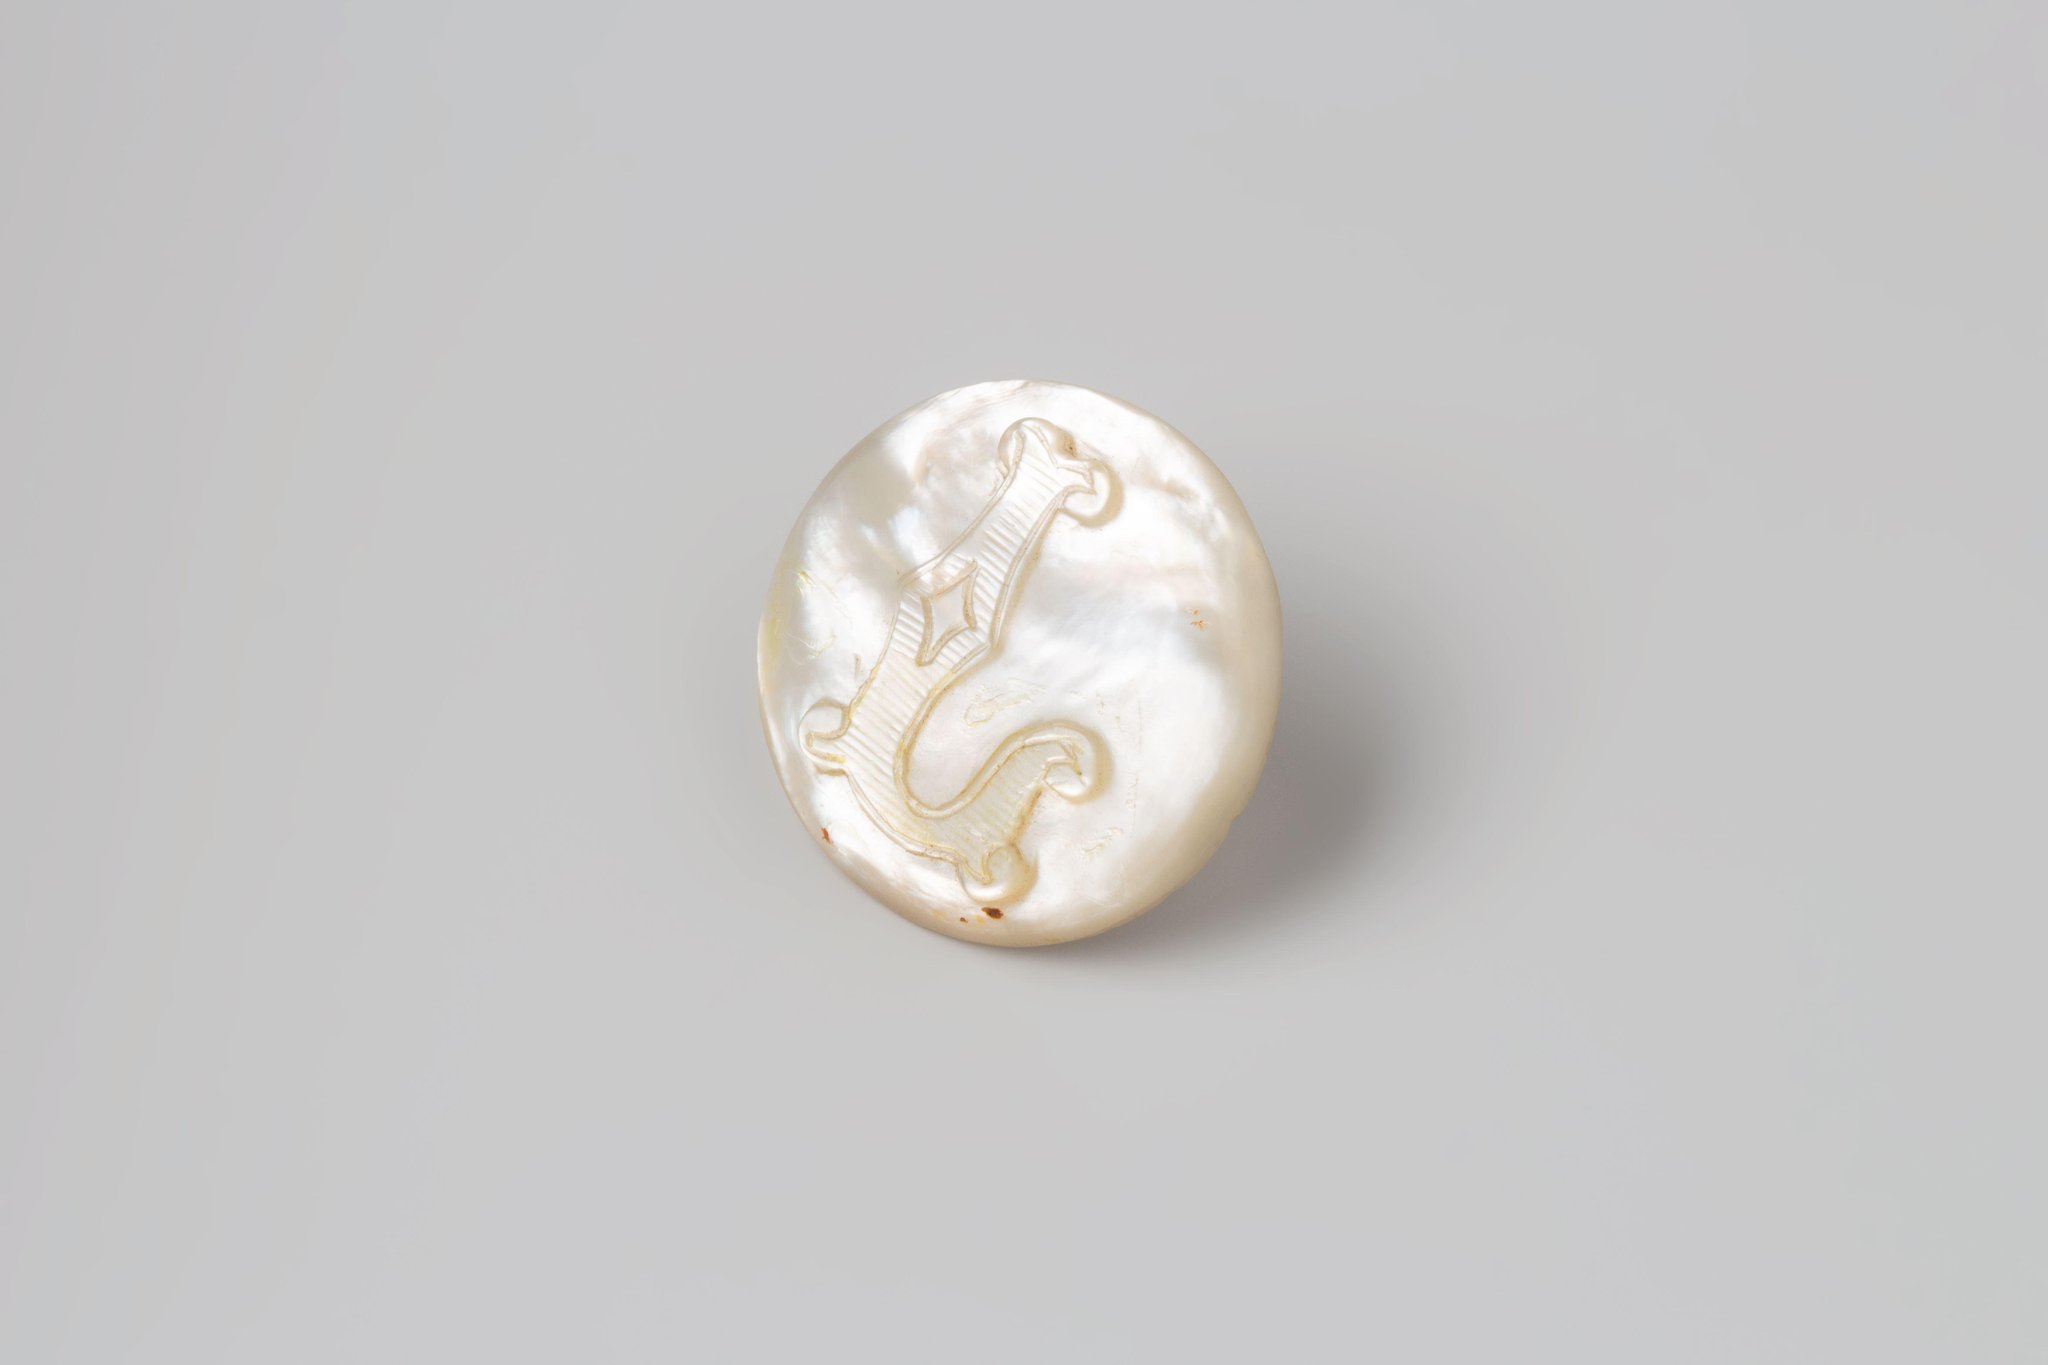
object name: cuff link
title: Manchetknoop van parelmoer met letter L in reliëf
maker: Anonymous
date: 1870-1880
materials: metal, mother of pearl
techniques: engraving, forging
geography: netherlands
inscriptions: initials: ‘'L'’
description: Manchetknopen van parelmoer met de letter "L" in reliëf en metalen klem.